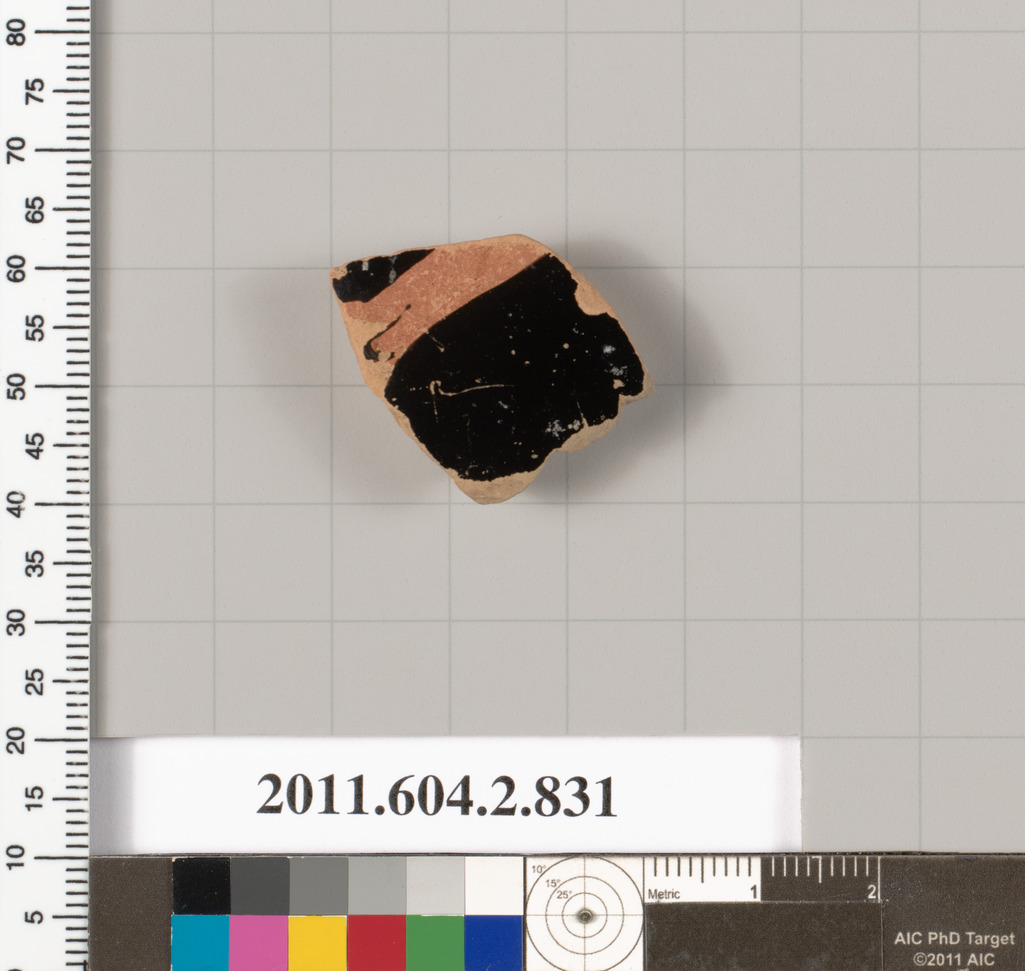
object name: bell krater fragment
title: Terracotta fragment of a bell-krater (bowl for mixing wine and water)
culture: greek, attic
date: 467-435 BCE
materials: terracotta